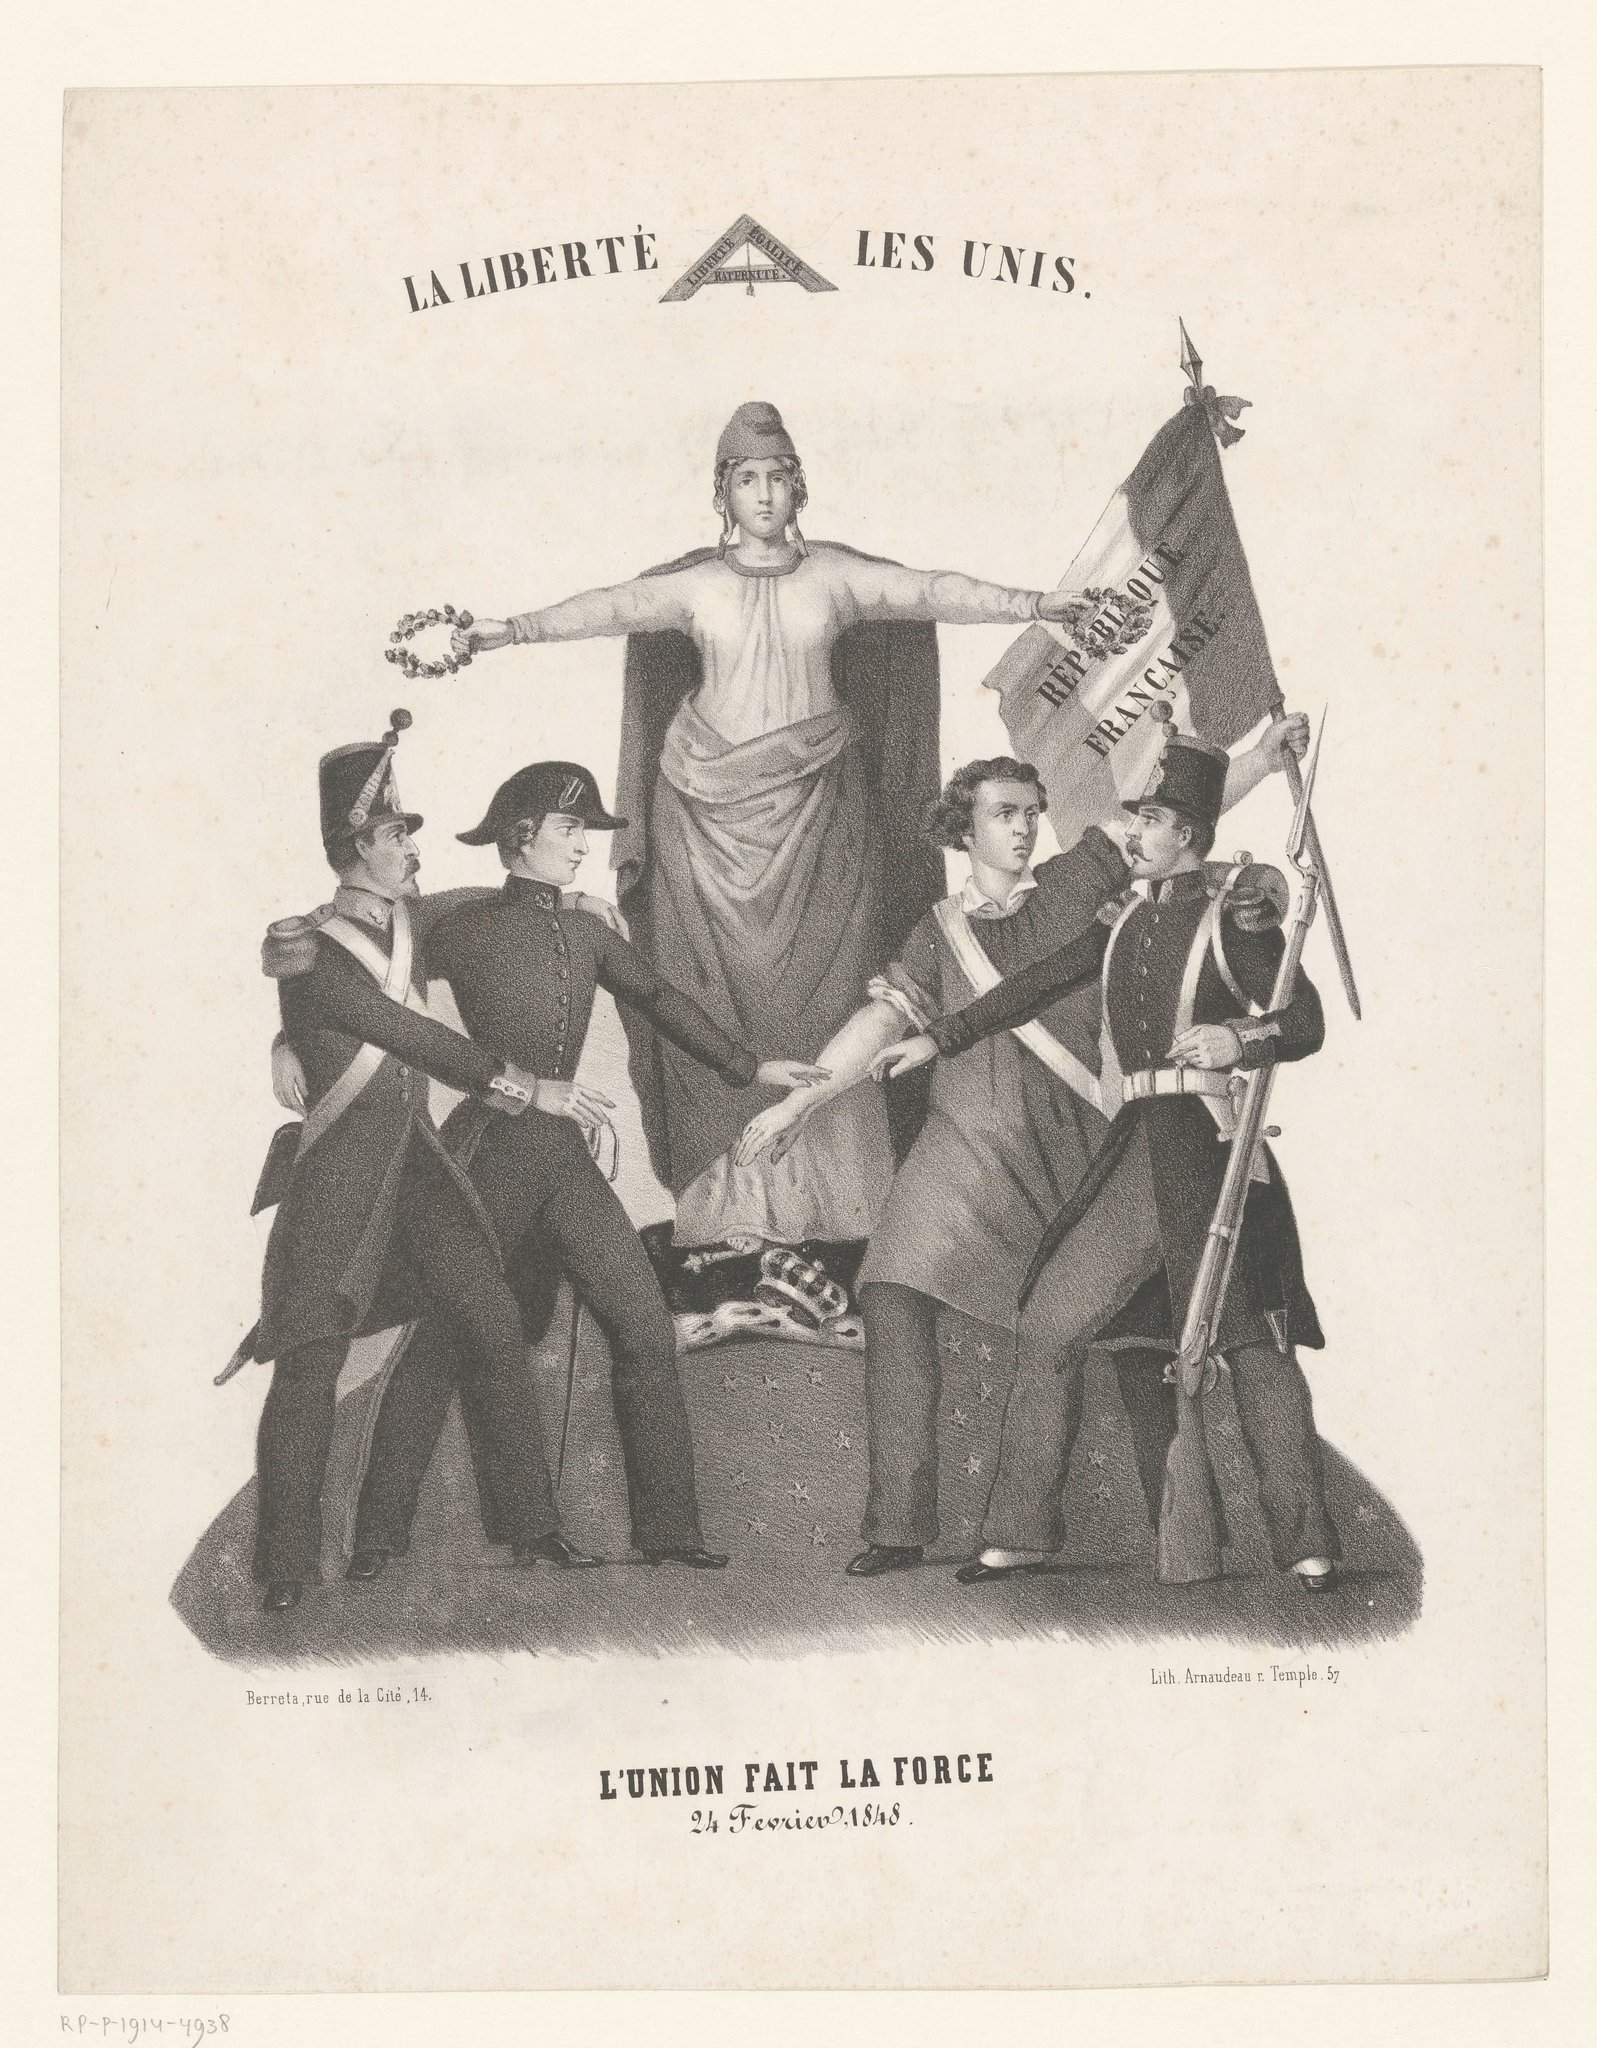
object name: print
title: La liberté les unis / L'union fait la Force / 24 Fevrier 1848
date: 1848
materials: paper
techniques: lithograph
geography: paris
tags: personifications of countries, nations, states, districts, etc., france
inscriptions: collector's mark: Lugt 2228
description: Allegorie op de Februarirevolutie in Frankrijk, 1848. Marianne vertreedt symbolen van het koningshuis en houdt lauwerkransen boven de hoofden van de samenwerkende burgers en militairen.